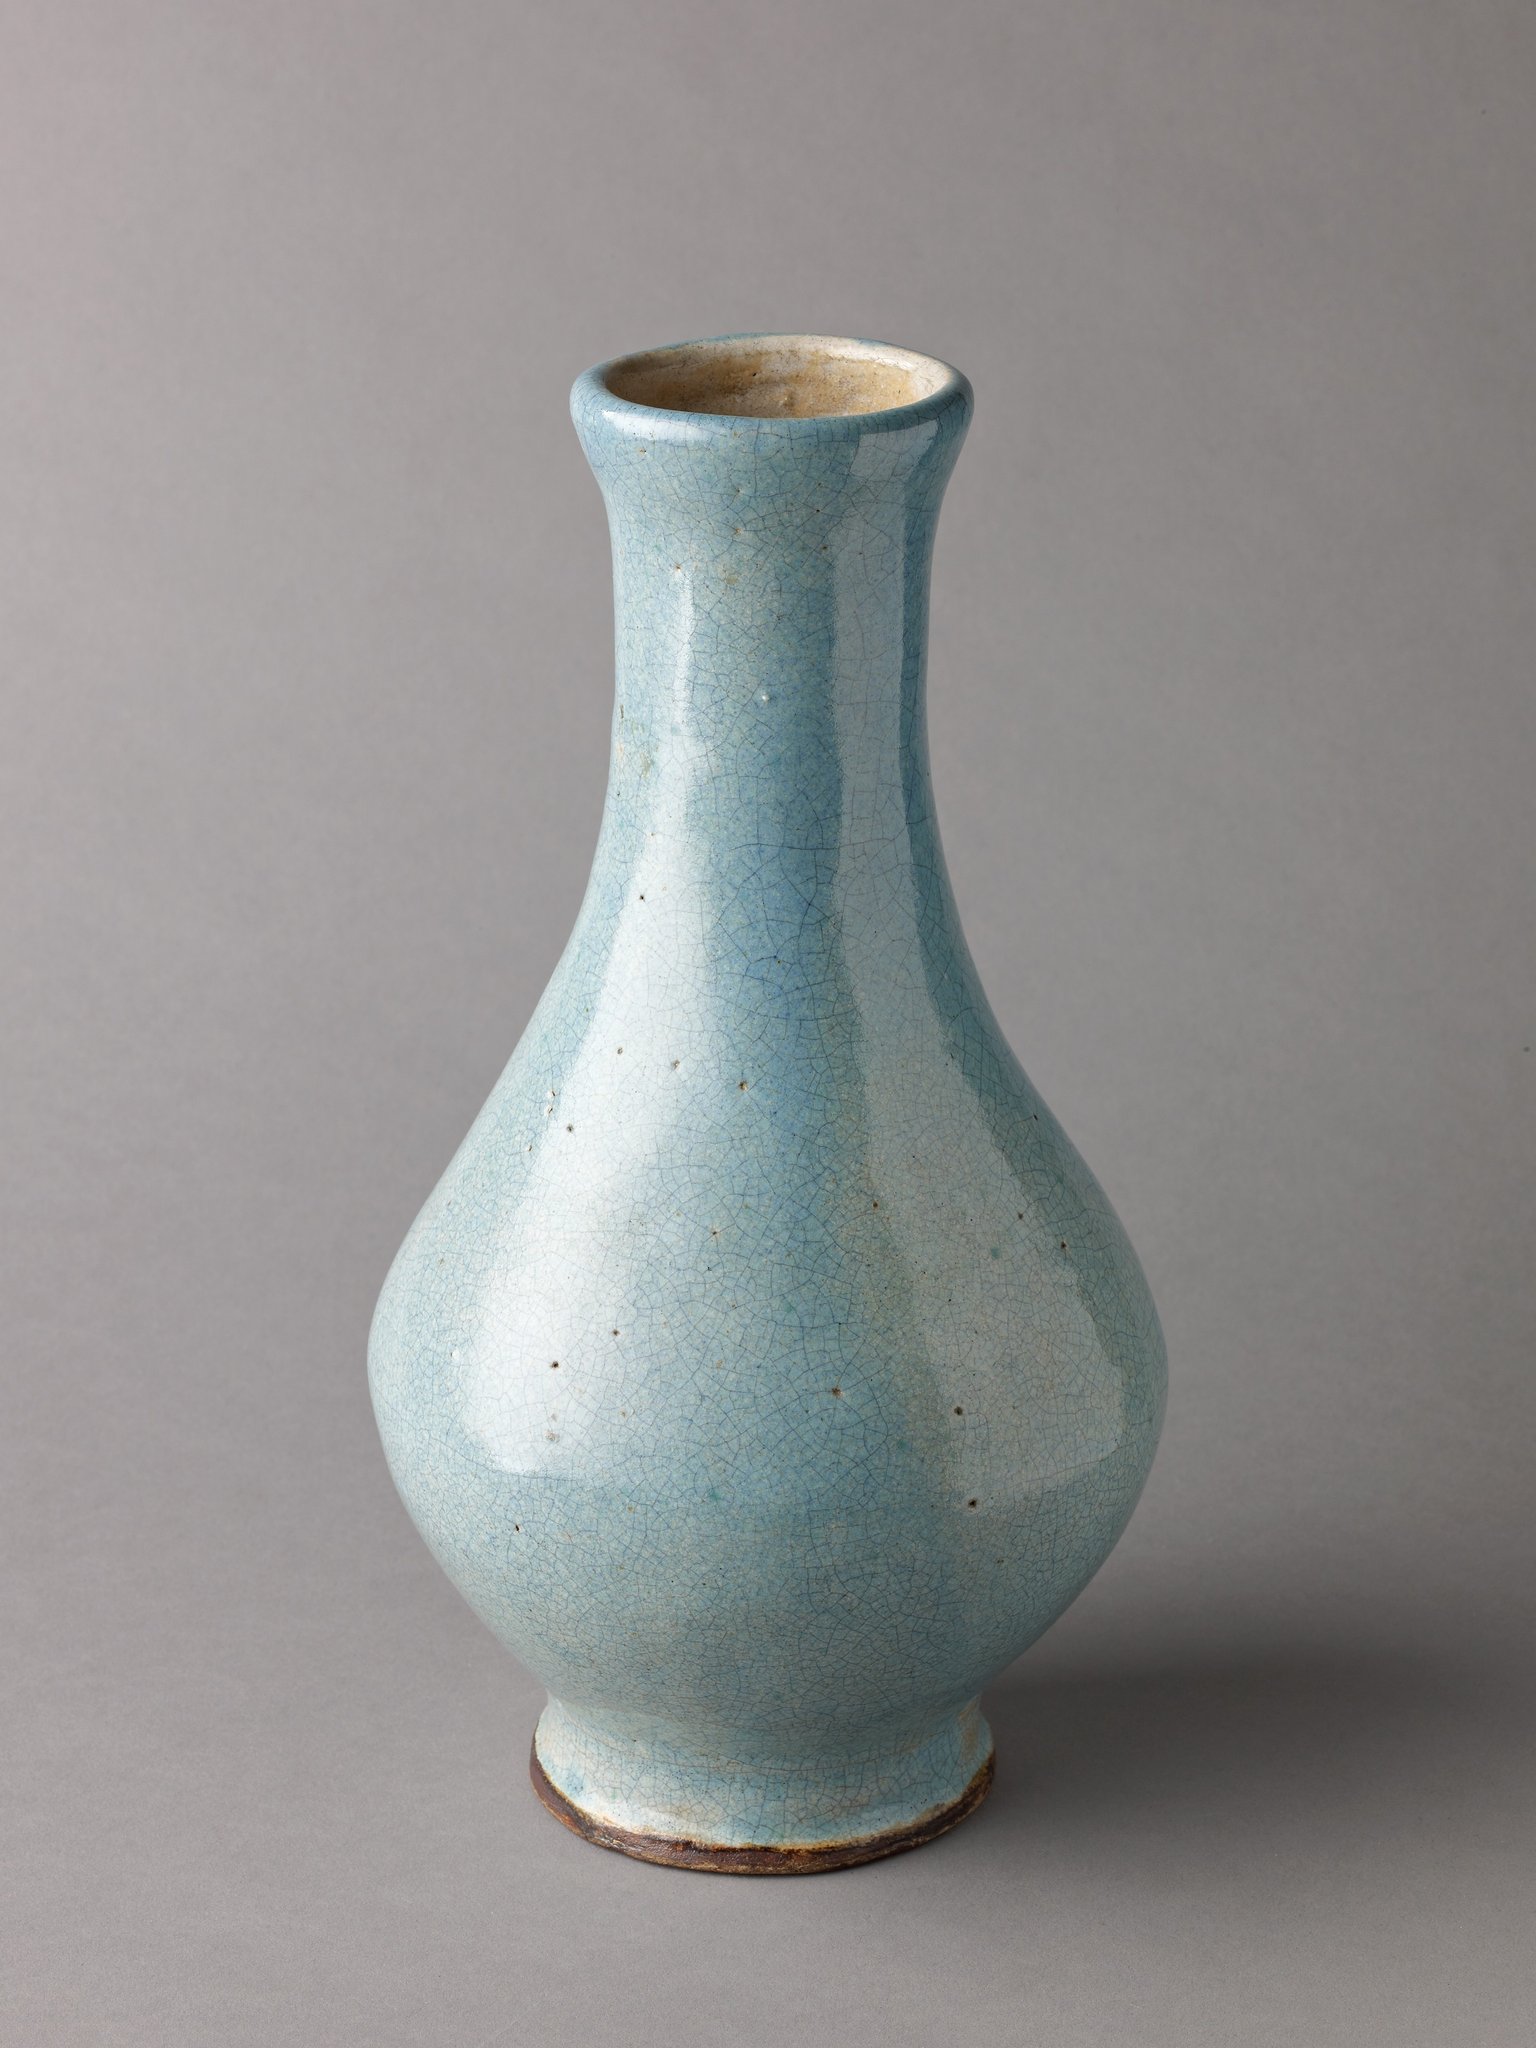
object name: vase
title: Pyriform vase, possibly an imitation of Song Guan ware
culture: chinese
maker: chinese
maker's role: artist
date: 1501-1700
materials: glaze, stoneware